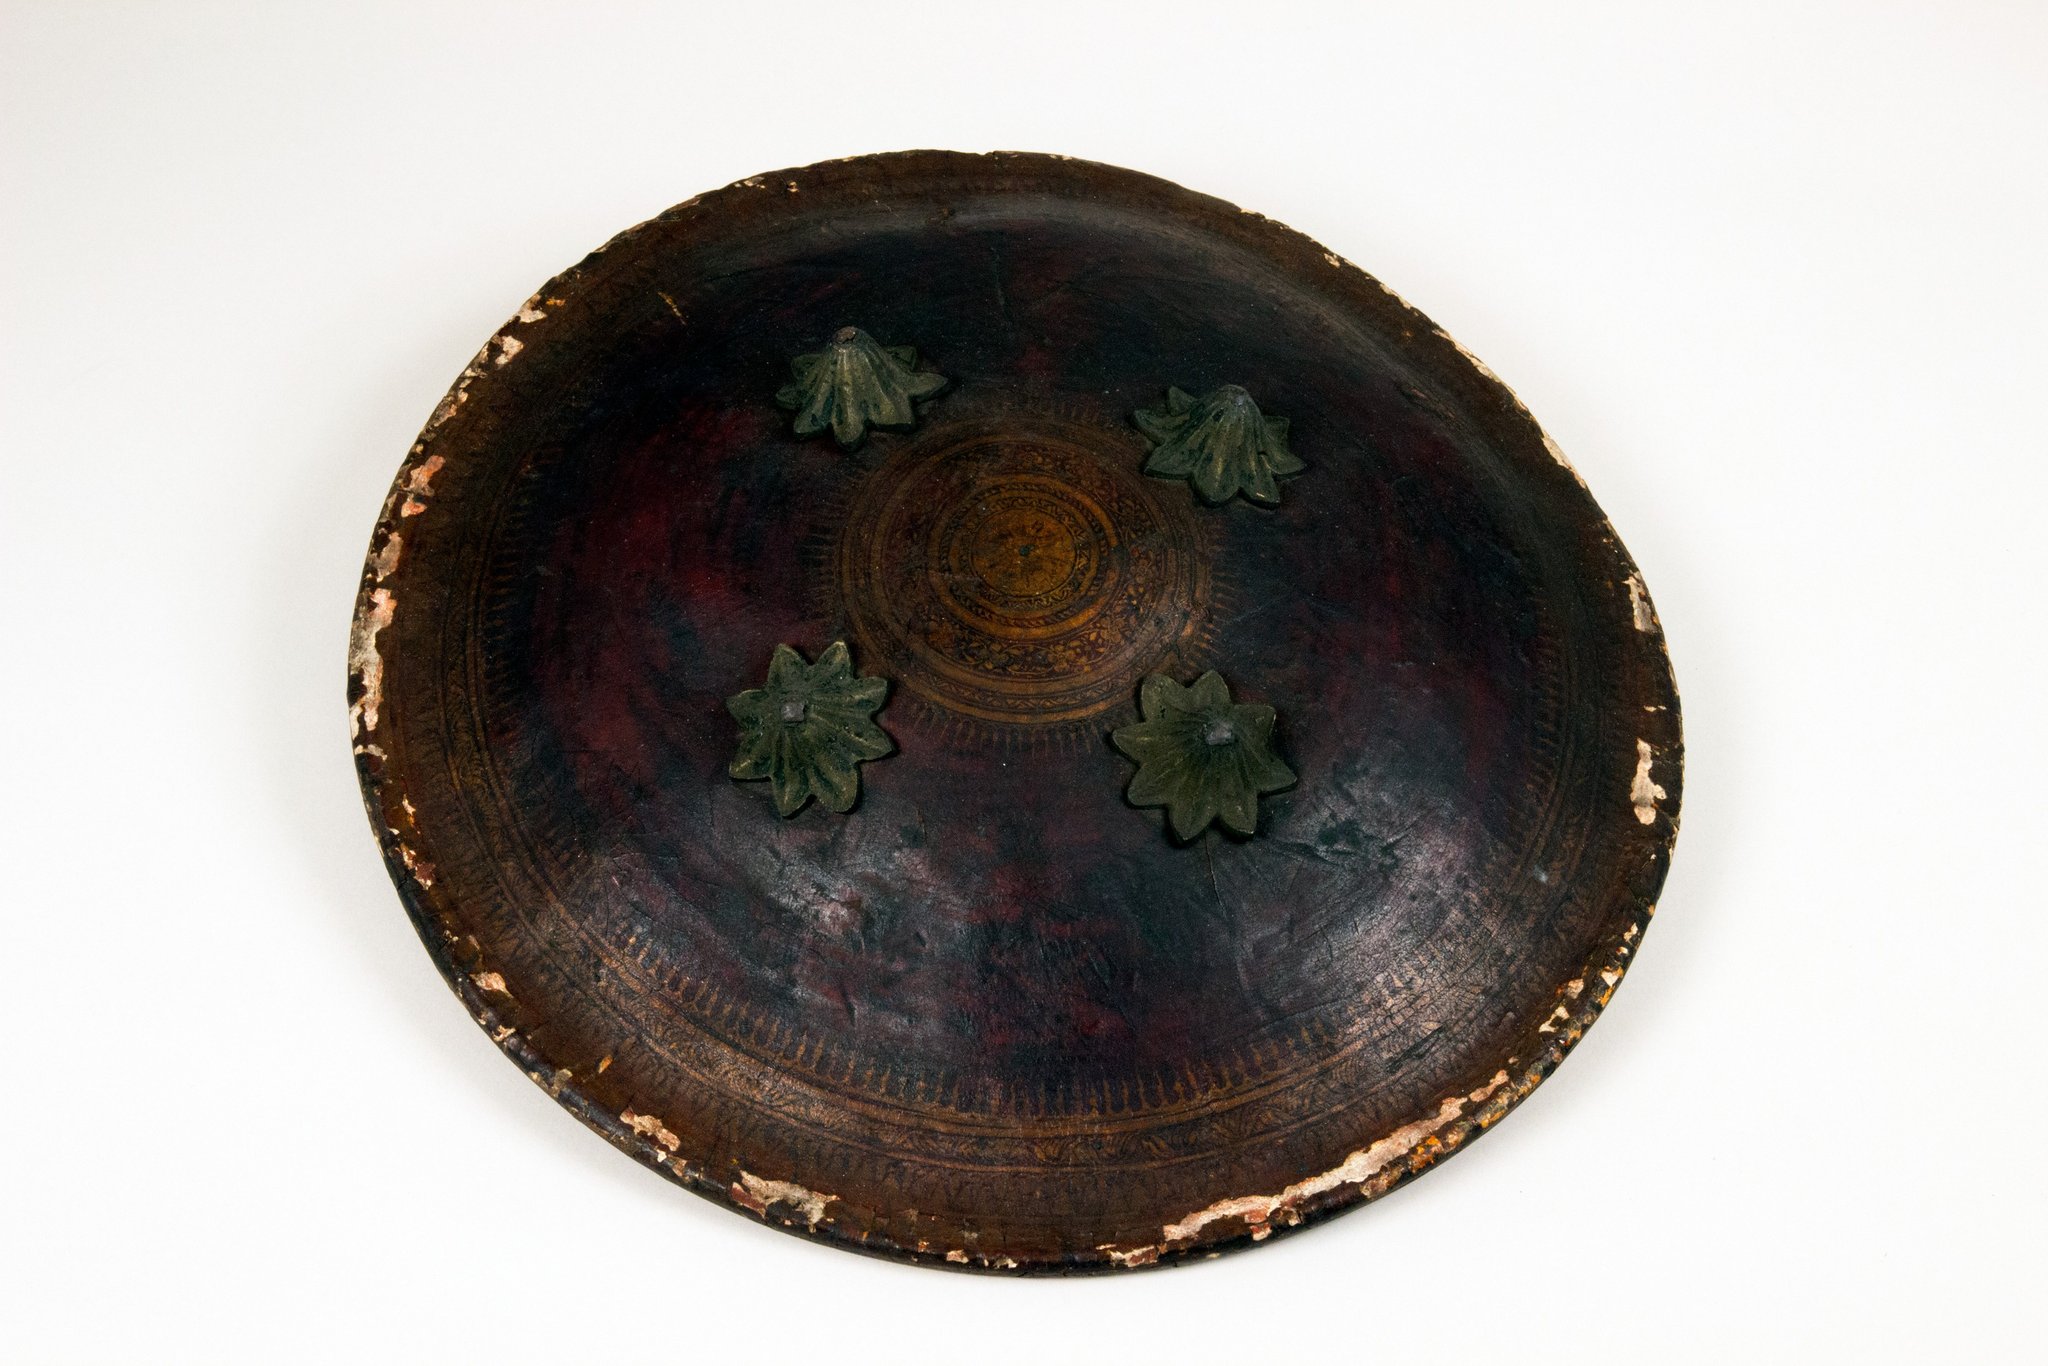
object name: shield dhàl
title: Shield (Dhàl)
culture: indian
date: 1701-1900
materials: copper alloy, lacquer, leather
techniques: polychromy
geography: india